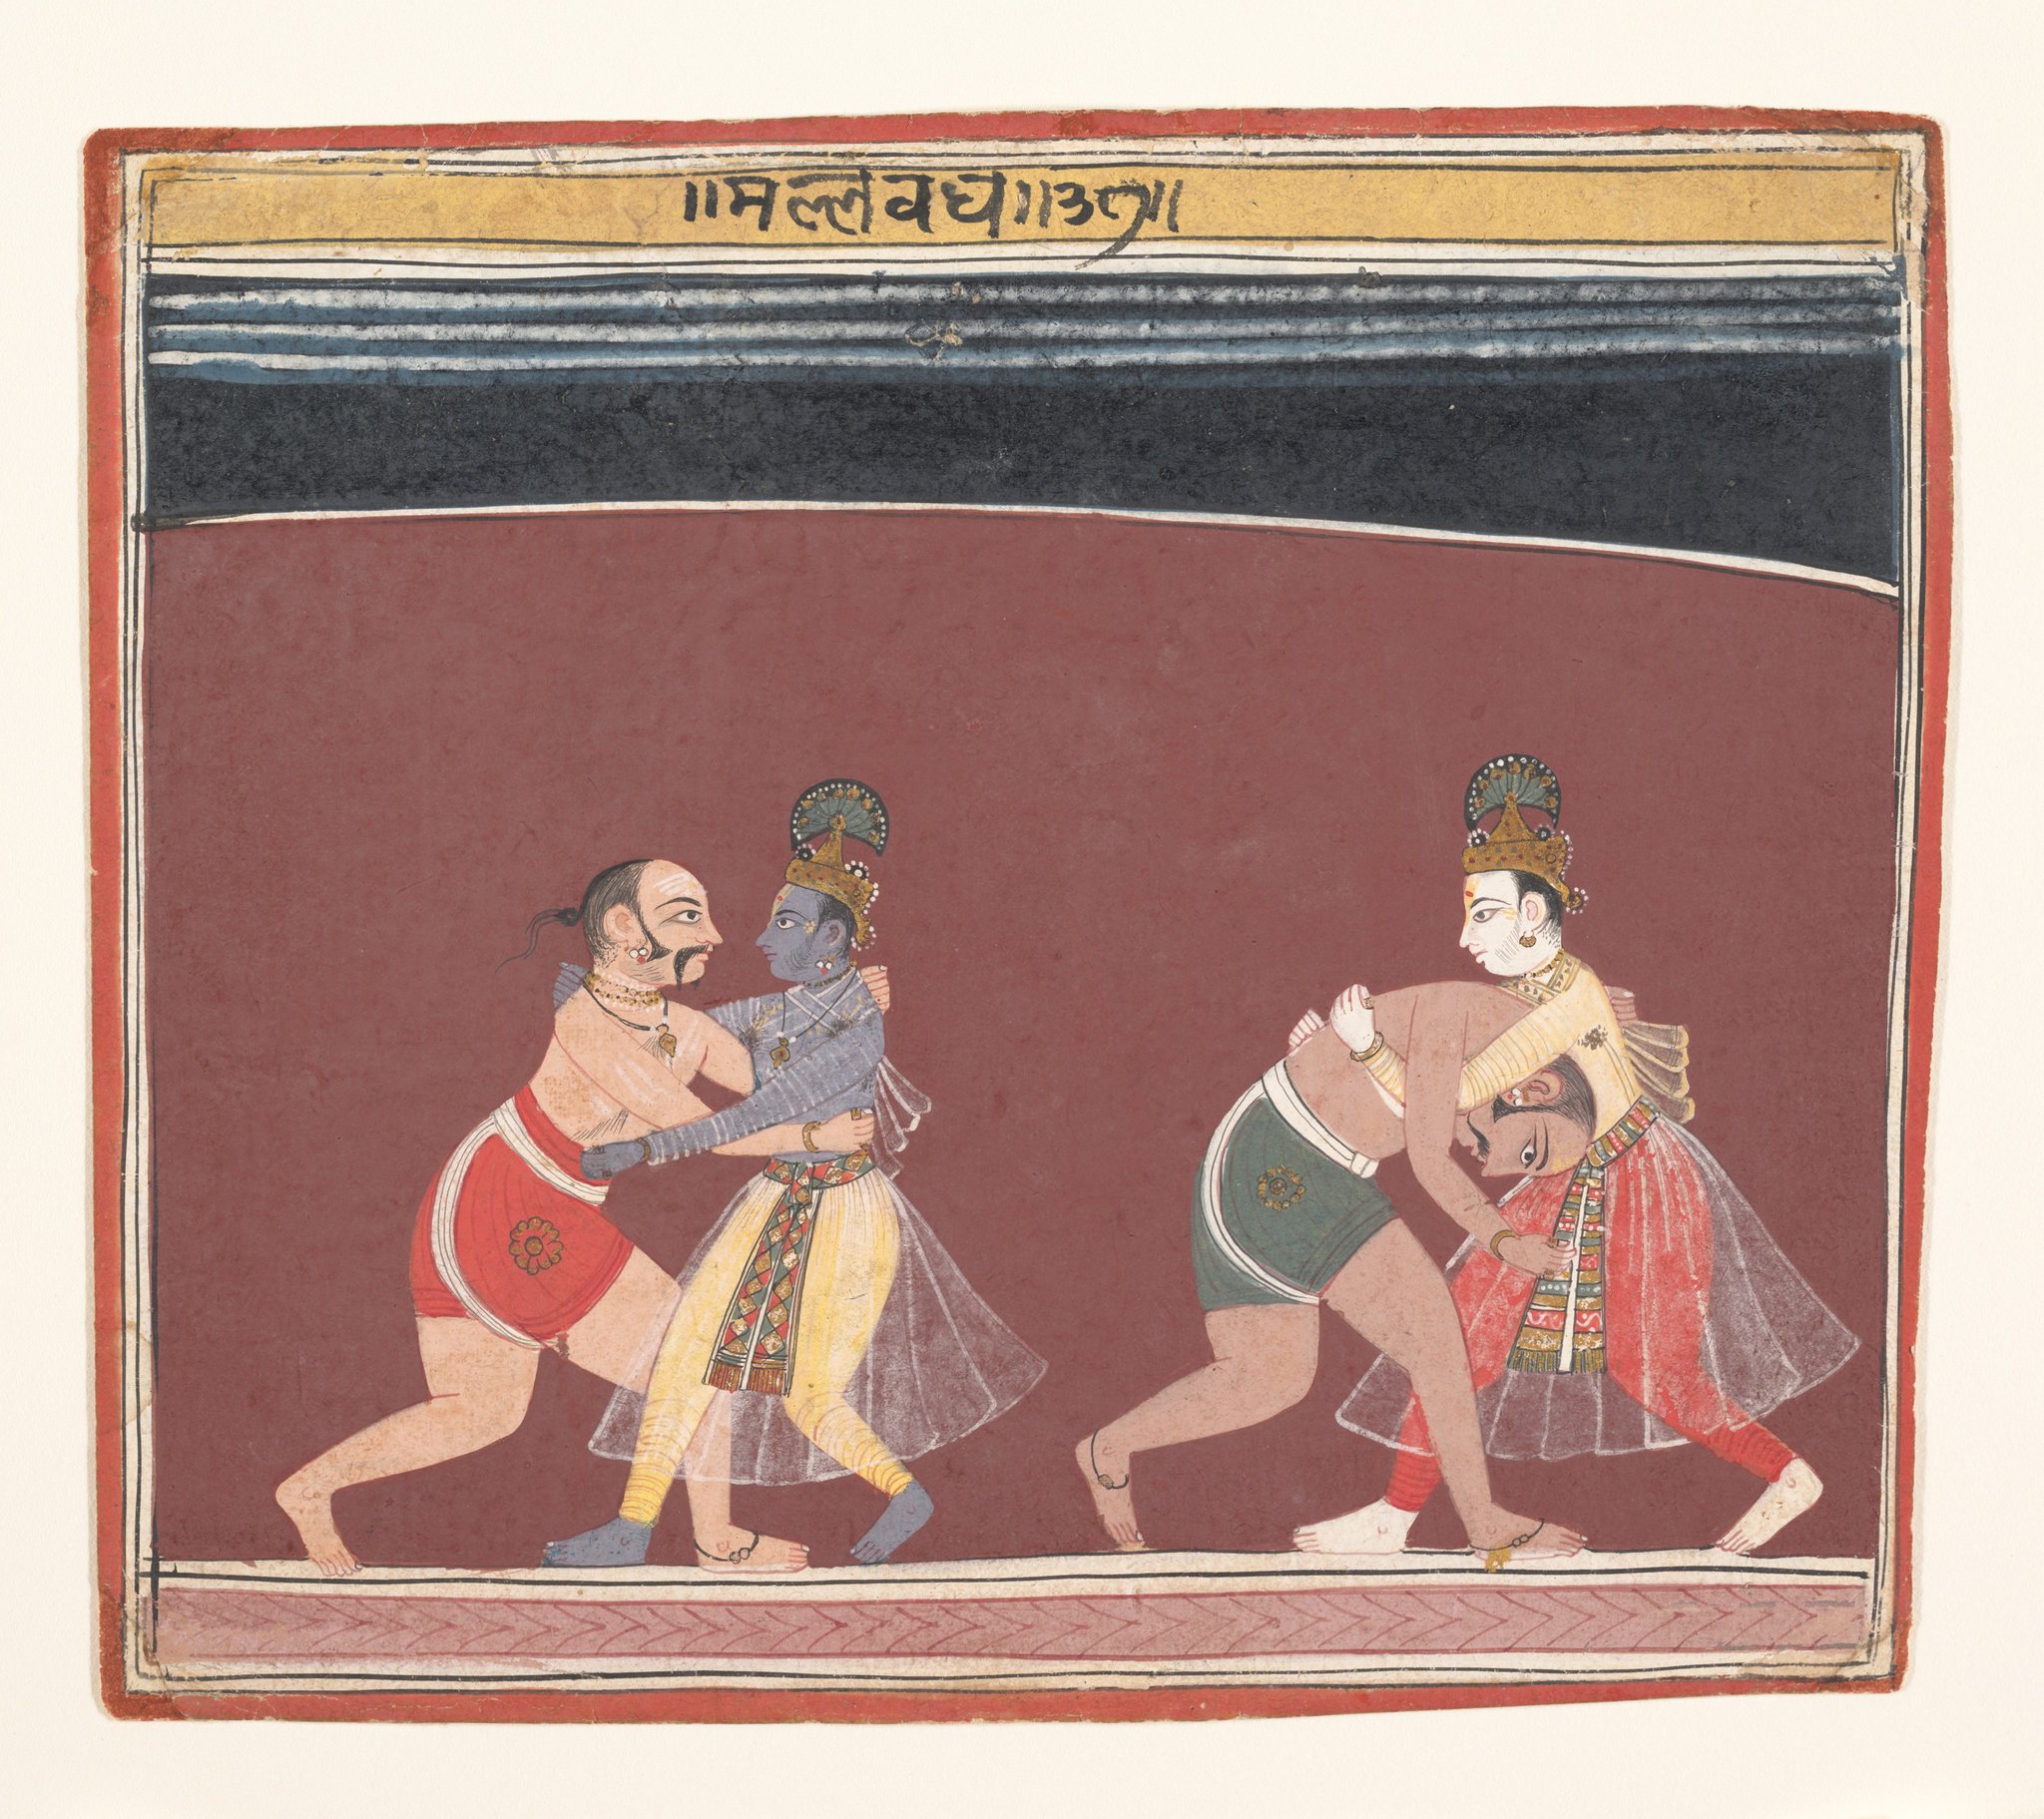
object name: folio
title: Krishna and Balarama Fight the Evil King Kamsa’s Wrestlers: Page from a Dispersed Bhagavata Purana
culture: indian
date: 1650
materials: ink, paper, watercolor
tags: men,krishna,wrestling